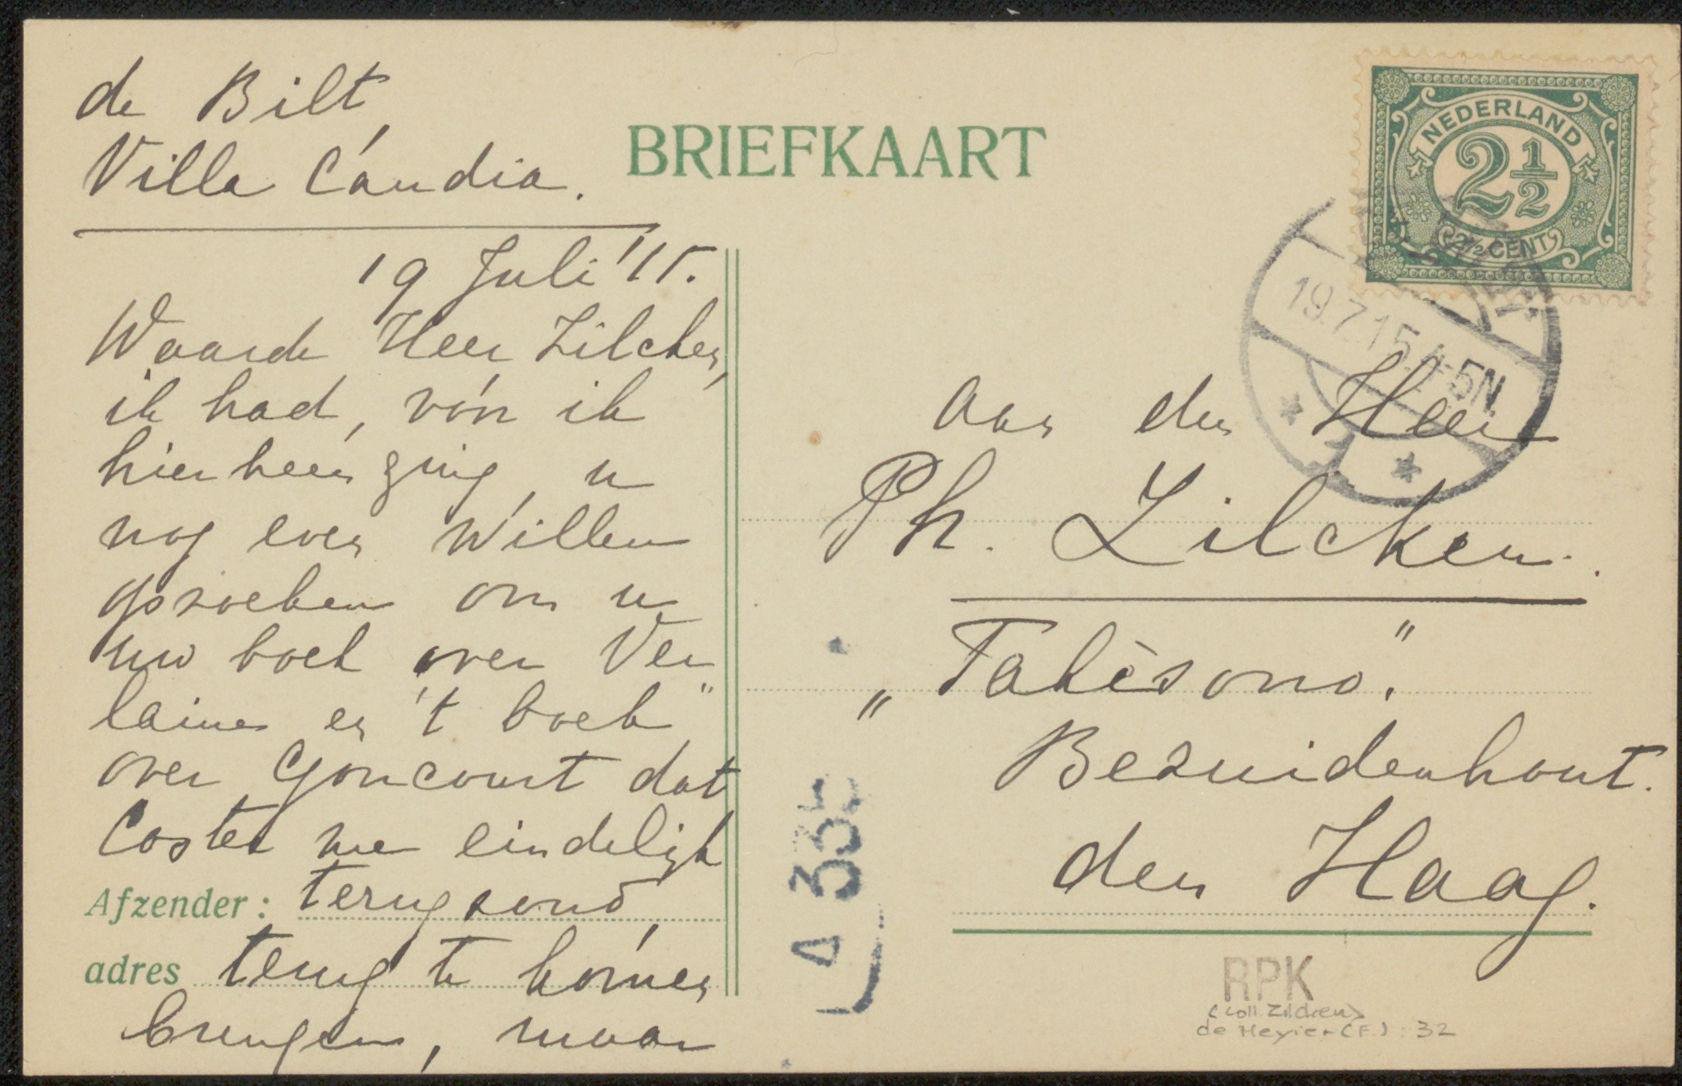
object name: postcard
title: Briefkaart aan Philip Zilcken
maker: fenna de meyier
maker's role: onderwijzer, schrijver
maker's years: 1874-1943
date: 1915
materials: cardboard, ink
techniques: pen, writing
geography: de bilt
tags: paris, paul verlaine, the hague, painter, philip zilcken, family life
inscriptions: collector's mark: ‘RPK’